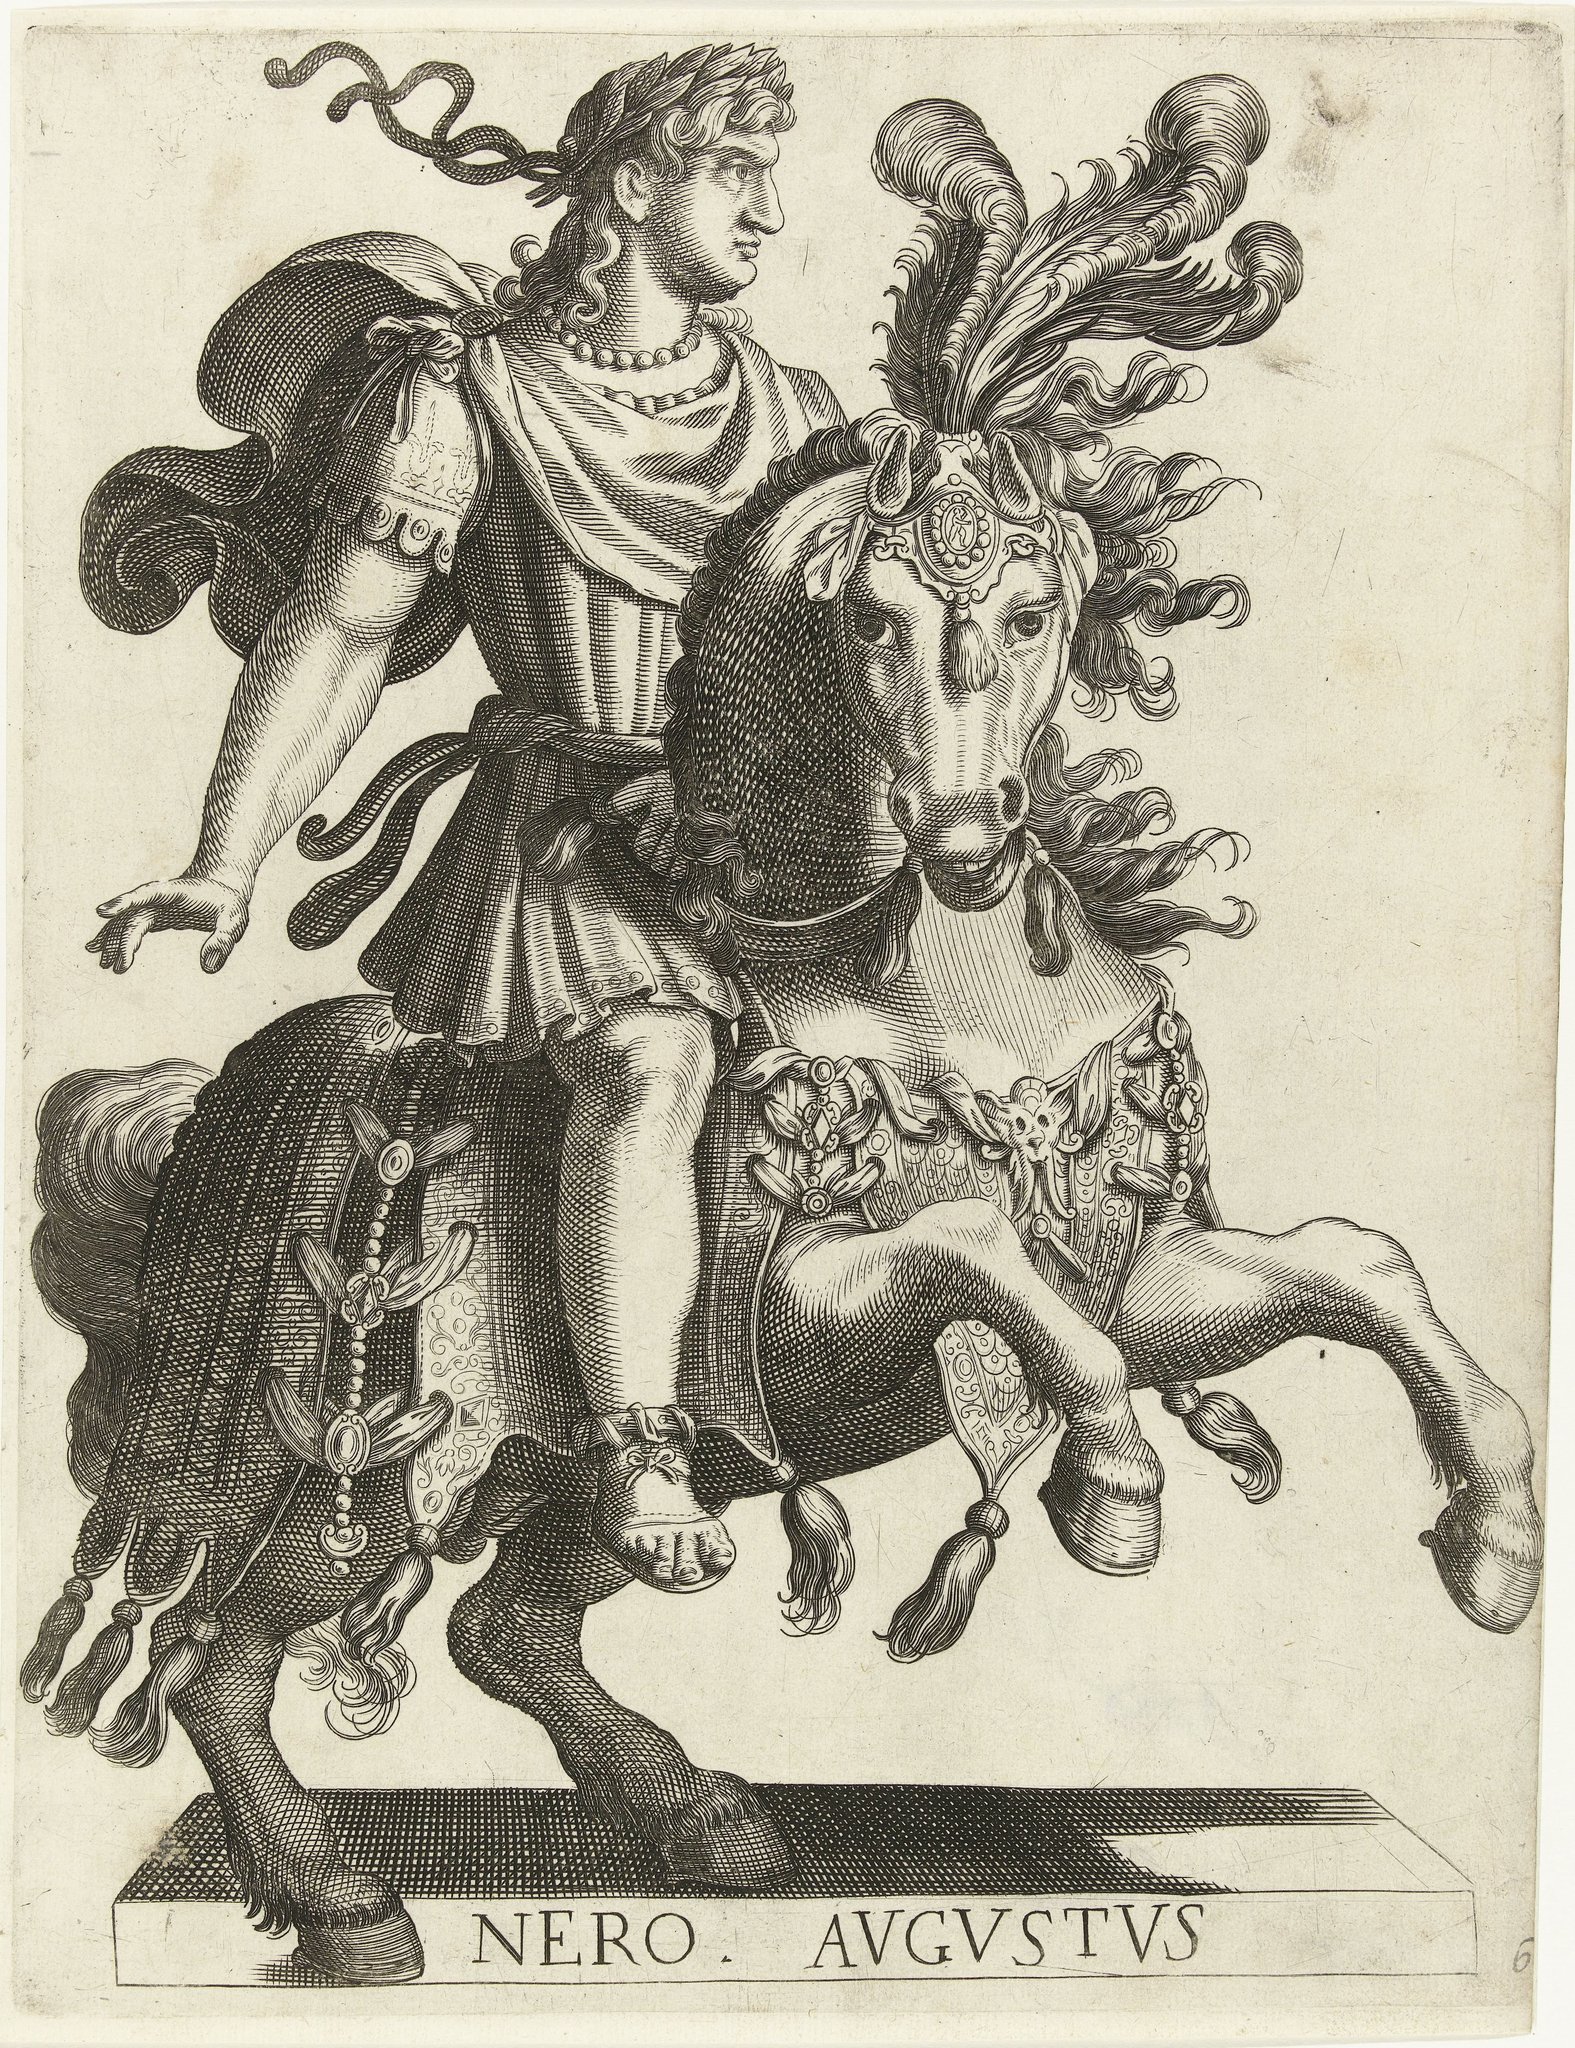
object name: print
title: Ruiterportret van keizer Nero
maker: laurens eillarts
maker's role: print maker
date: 1616-1620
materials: paper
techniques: engraving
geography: rome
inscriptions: collector's mark: Lugt 2228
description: Keizer Nero te paard, en profil afgebeeld met laurierkrans op het hoofd.